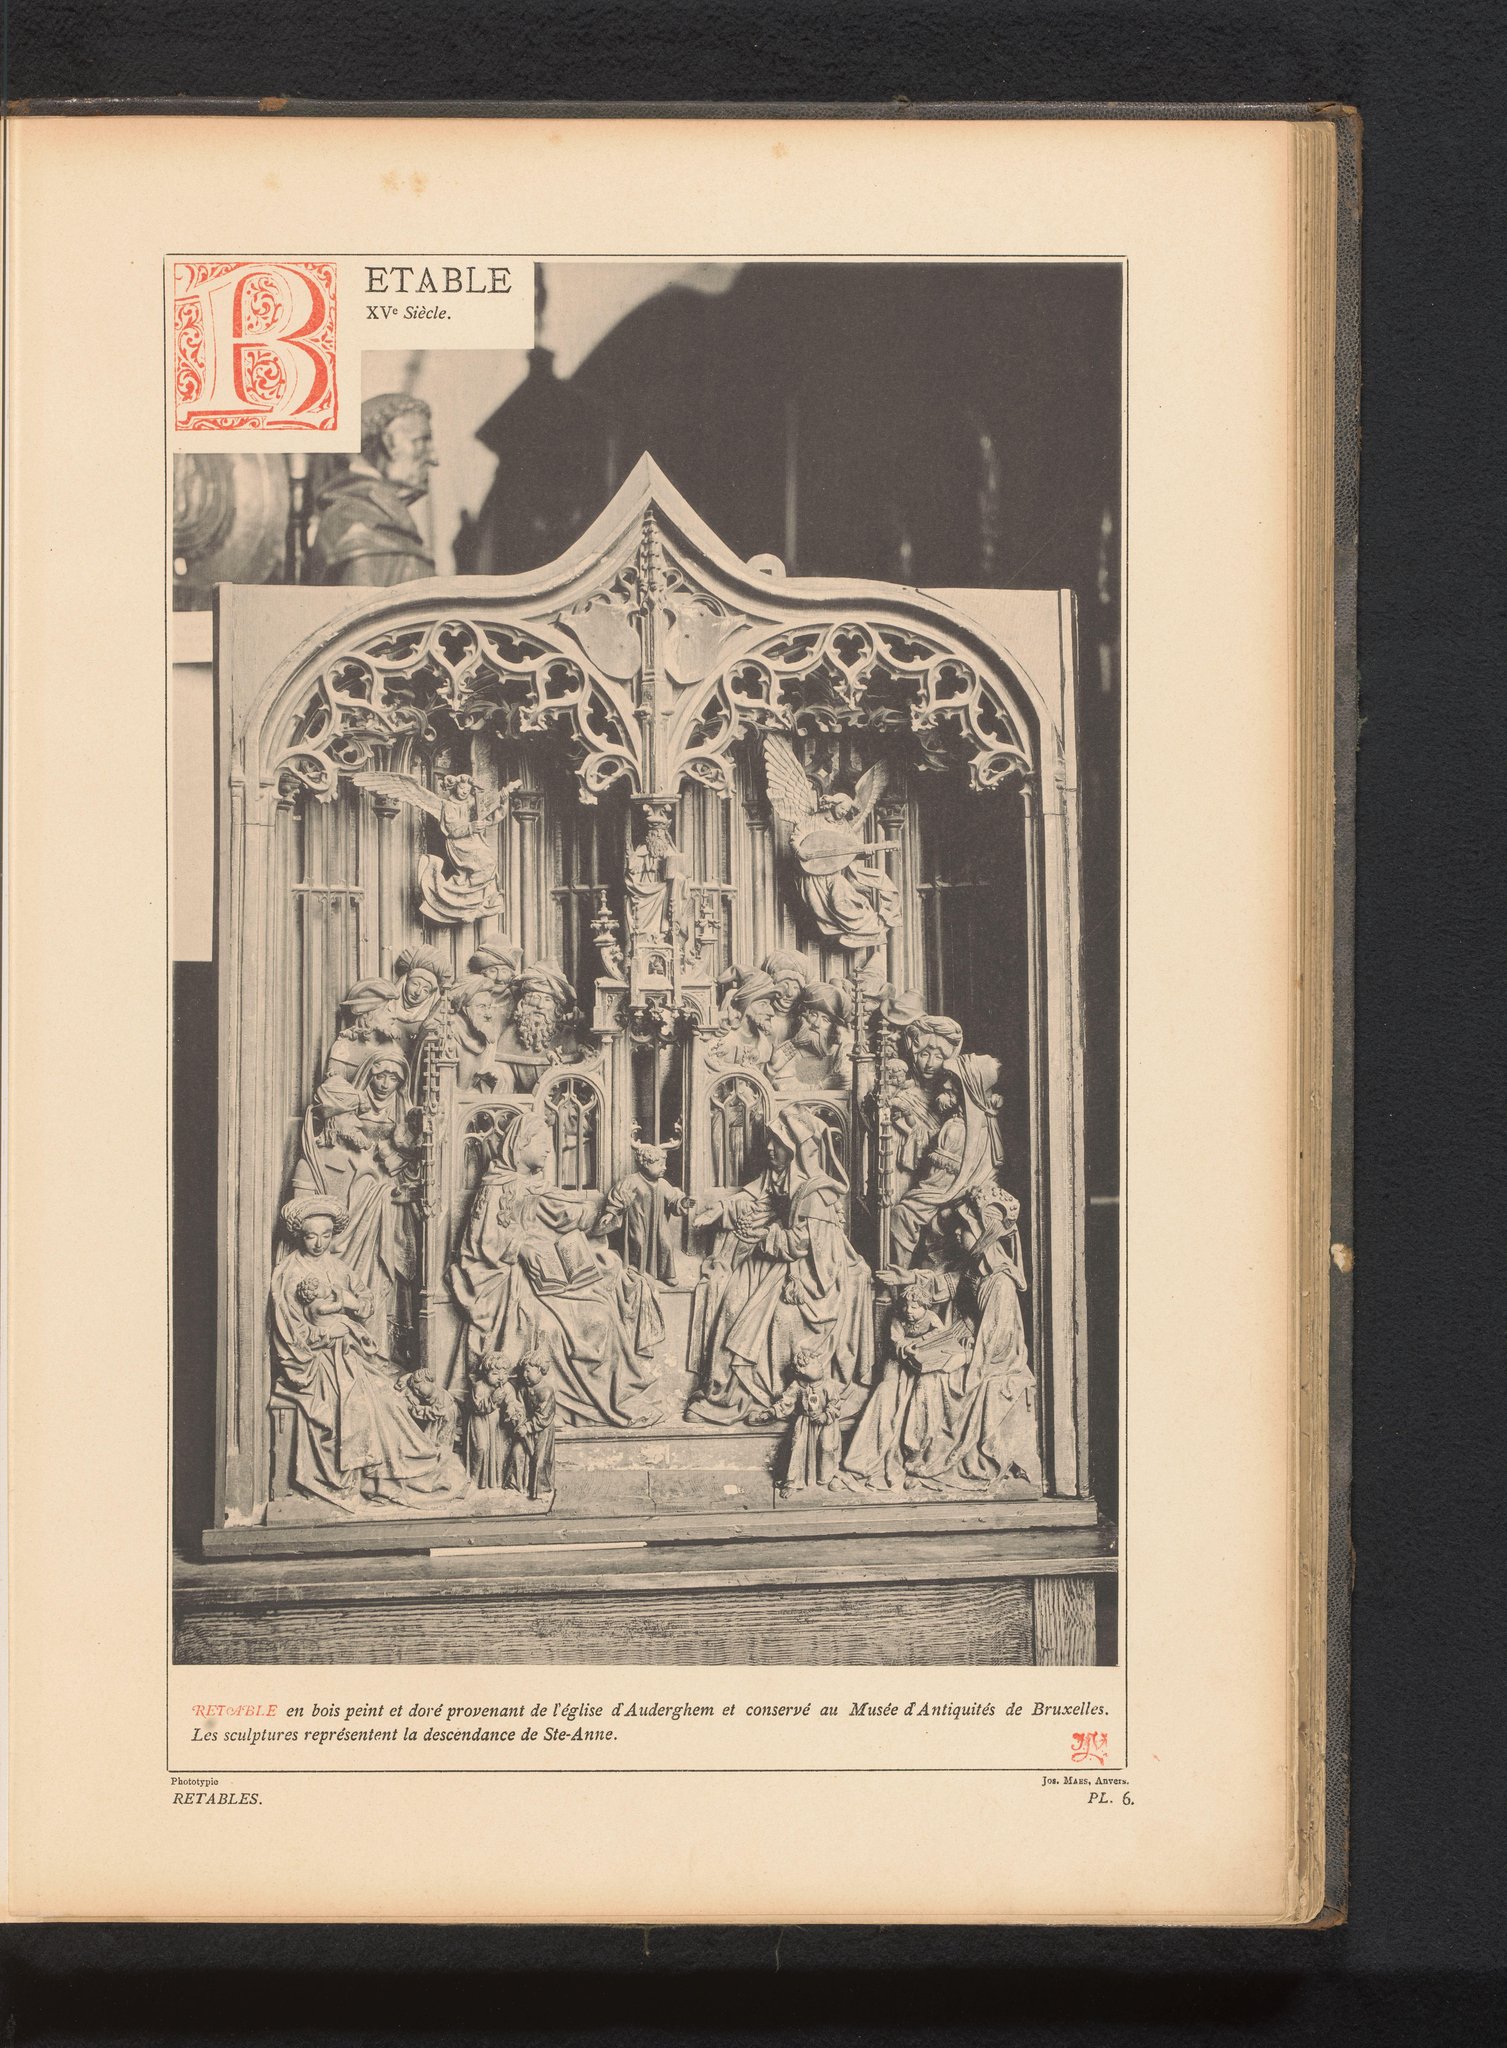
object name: page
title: Houten retabel in de Sint-Annakerk te Oudergem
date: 1881-1889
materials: paper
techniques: photograph, photolithography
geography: antwerp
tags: altar with altar-piece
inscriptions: inscription: ‘RETABLE en bois (...)’, inscription: ‘RETABLES. PL. 6.’, monogram: ‘JJvY’